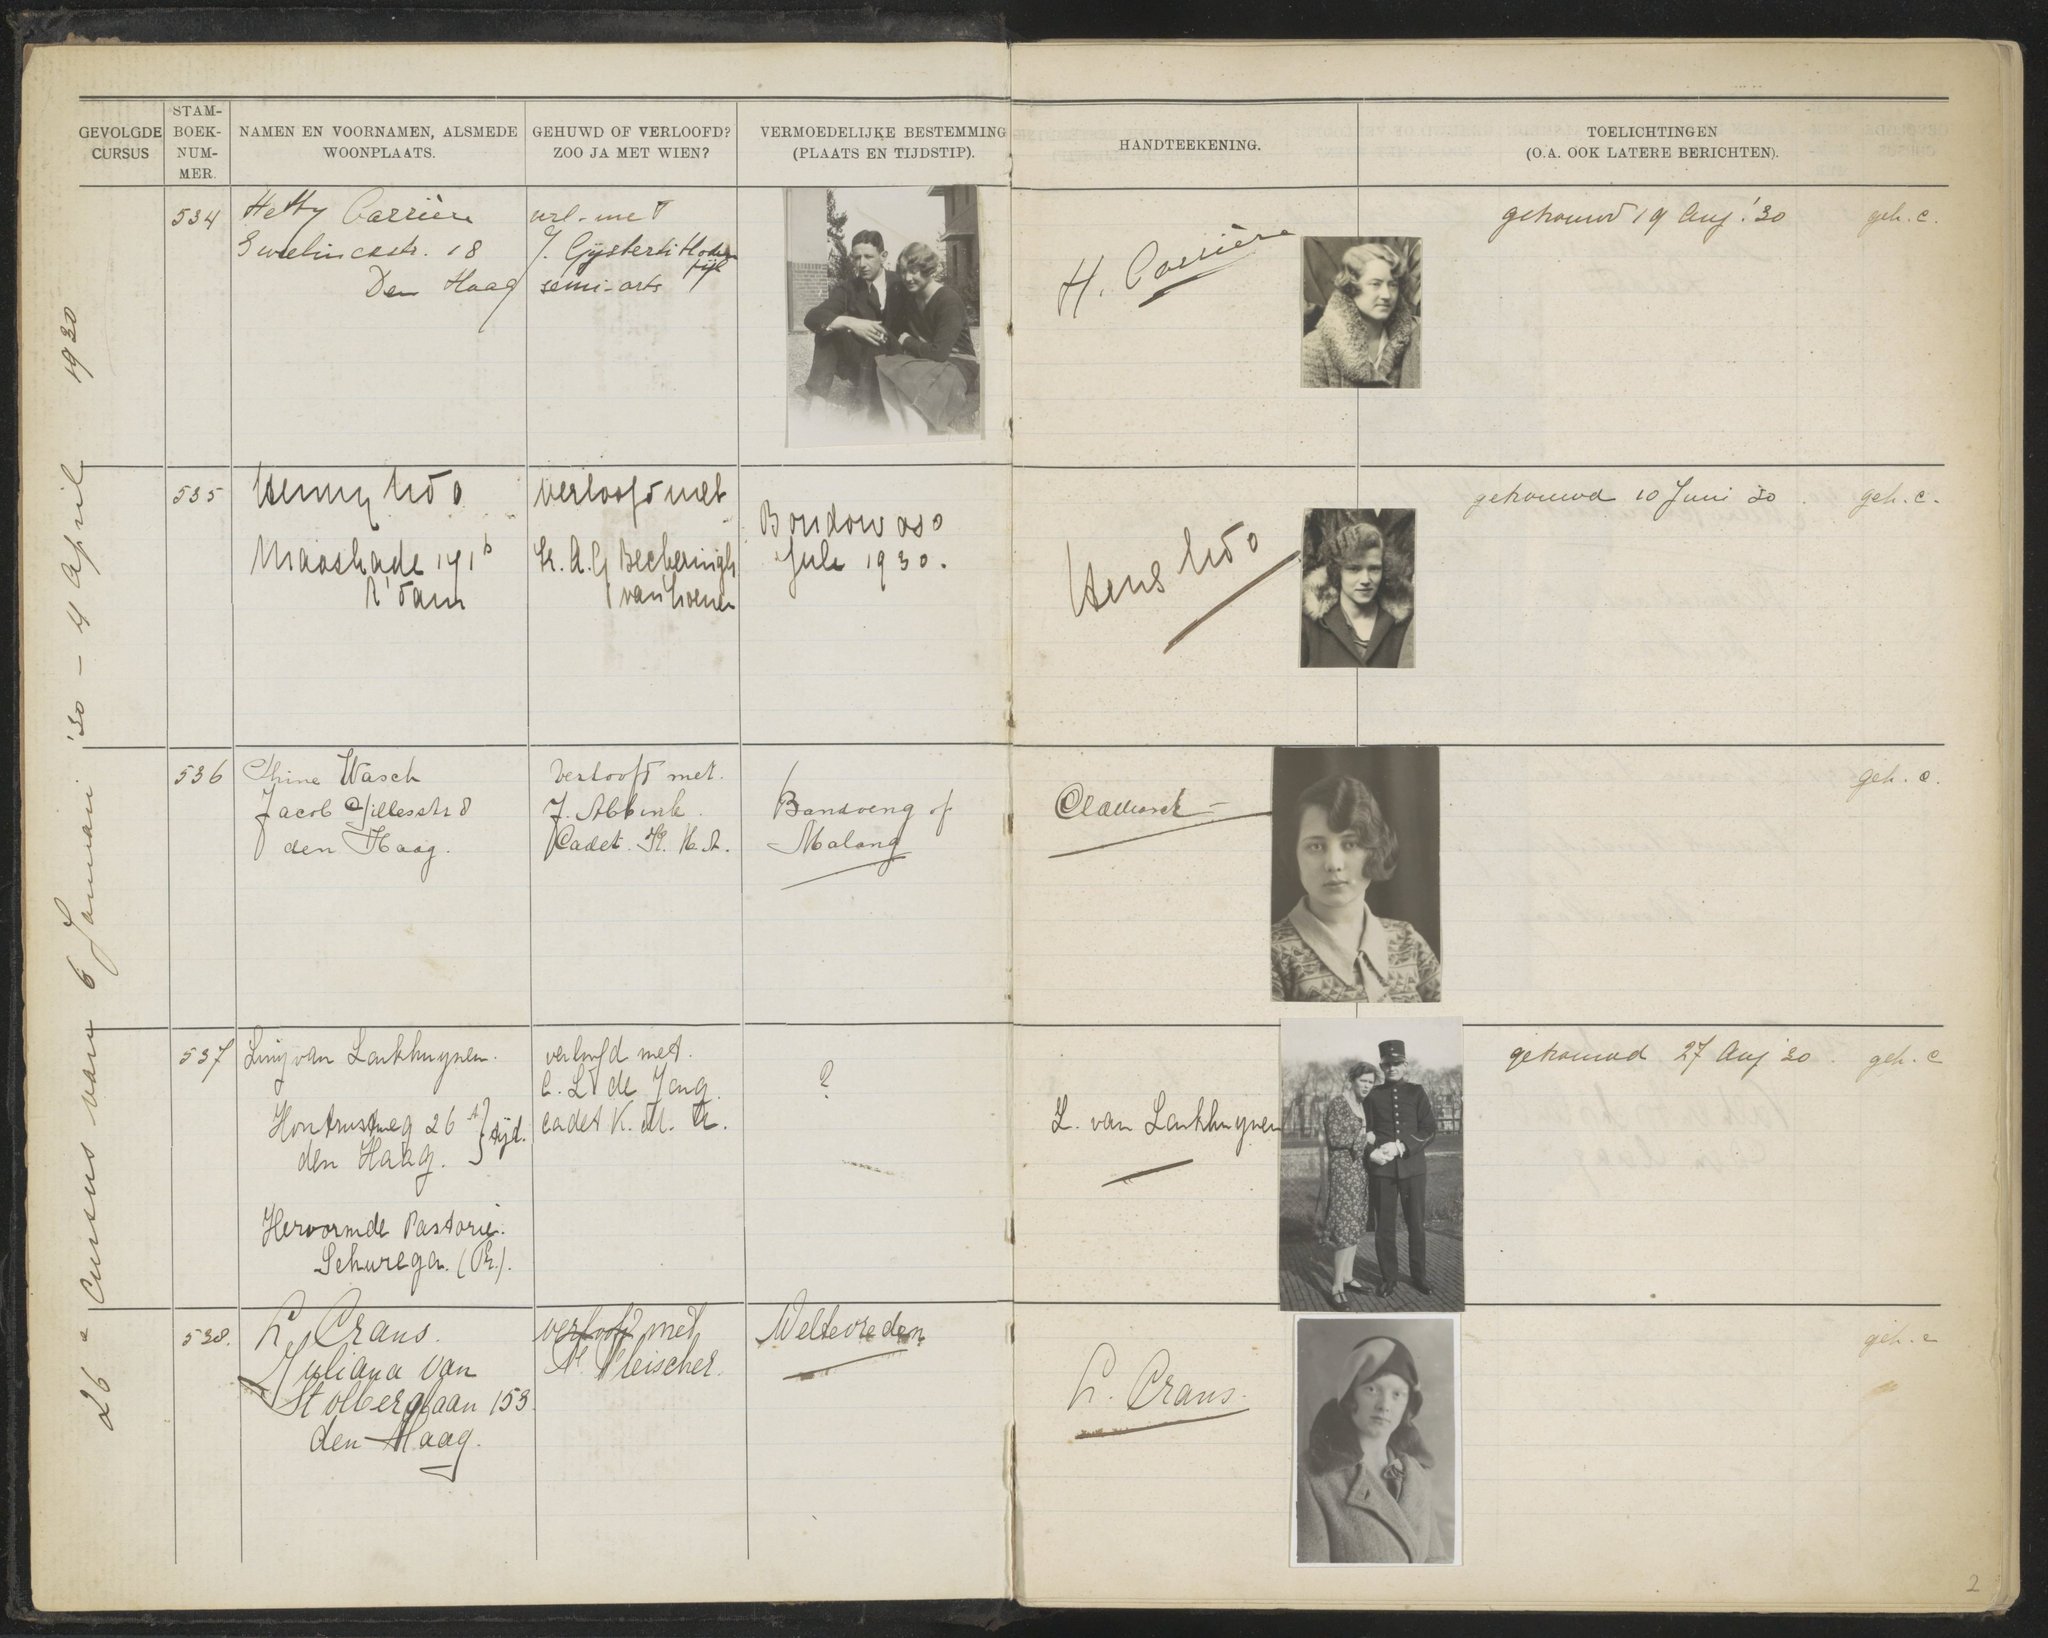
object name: album leaf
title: Blad 2 uit Stamboek van de leerlingen der Koloniale School voor Meisjes en Vrouwen te 's-Gravenhage deel II (1930-1949)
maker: Anonymous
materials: paper, photographic support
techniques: photography, printing, writing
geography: the hague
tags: further education (+ pupil), further education, the hague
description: Twee pagina's met gegevens van de deelnemers aan de 26e driemaandelijkse cursus van 6 januari 1930 tot en met 4 april 1930, stamboeknummers 534 tot en met 538. Onderdeel van Stamboek van de leerlingen der Koloniale School voor Meisjes en Vrouwen te 's-Gravenhage deel II (1930-1949).